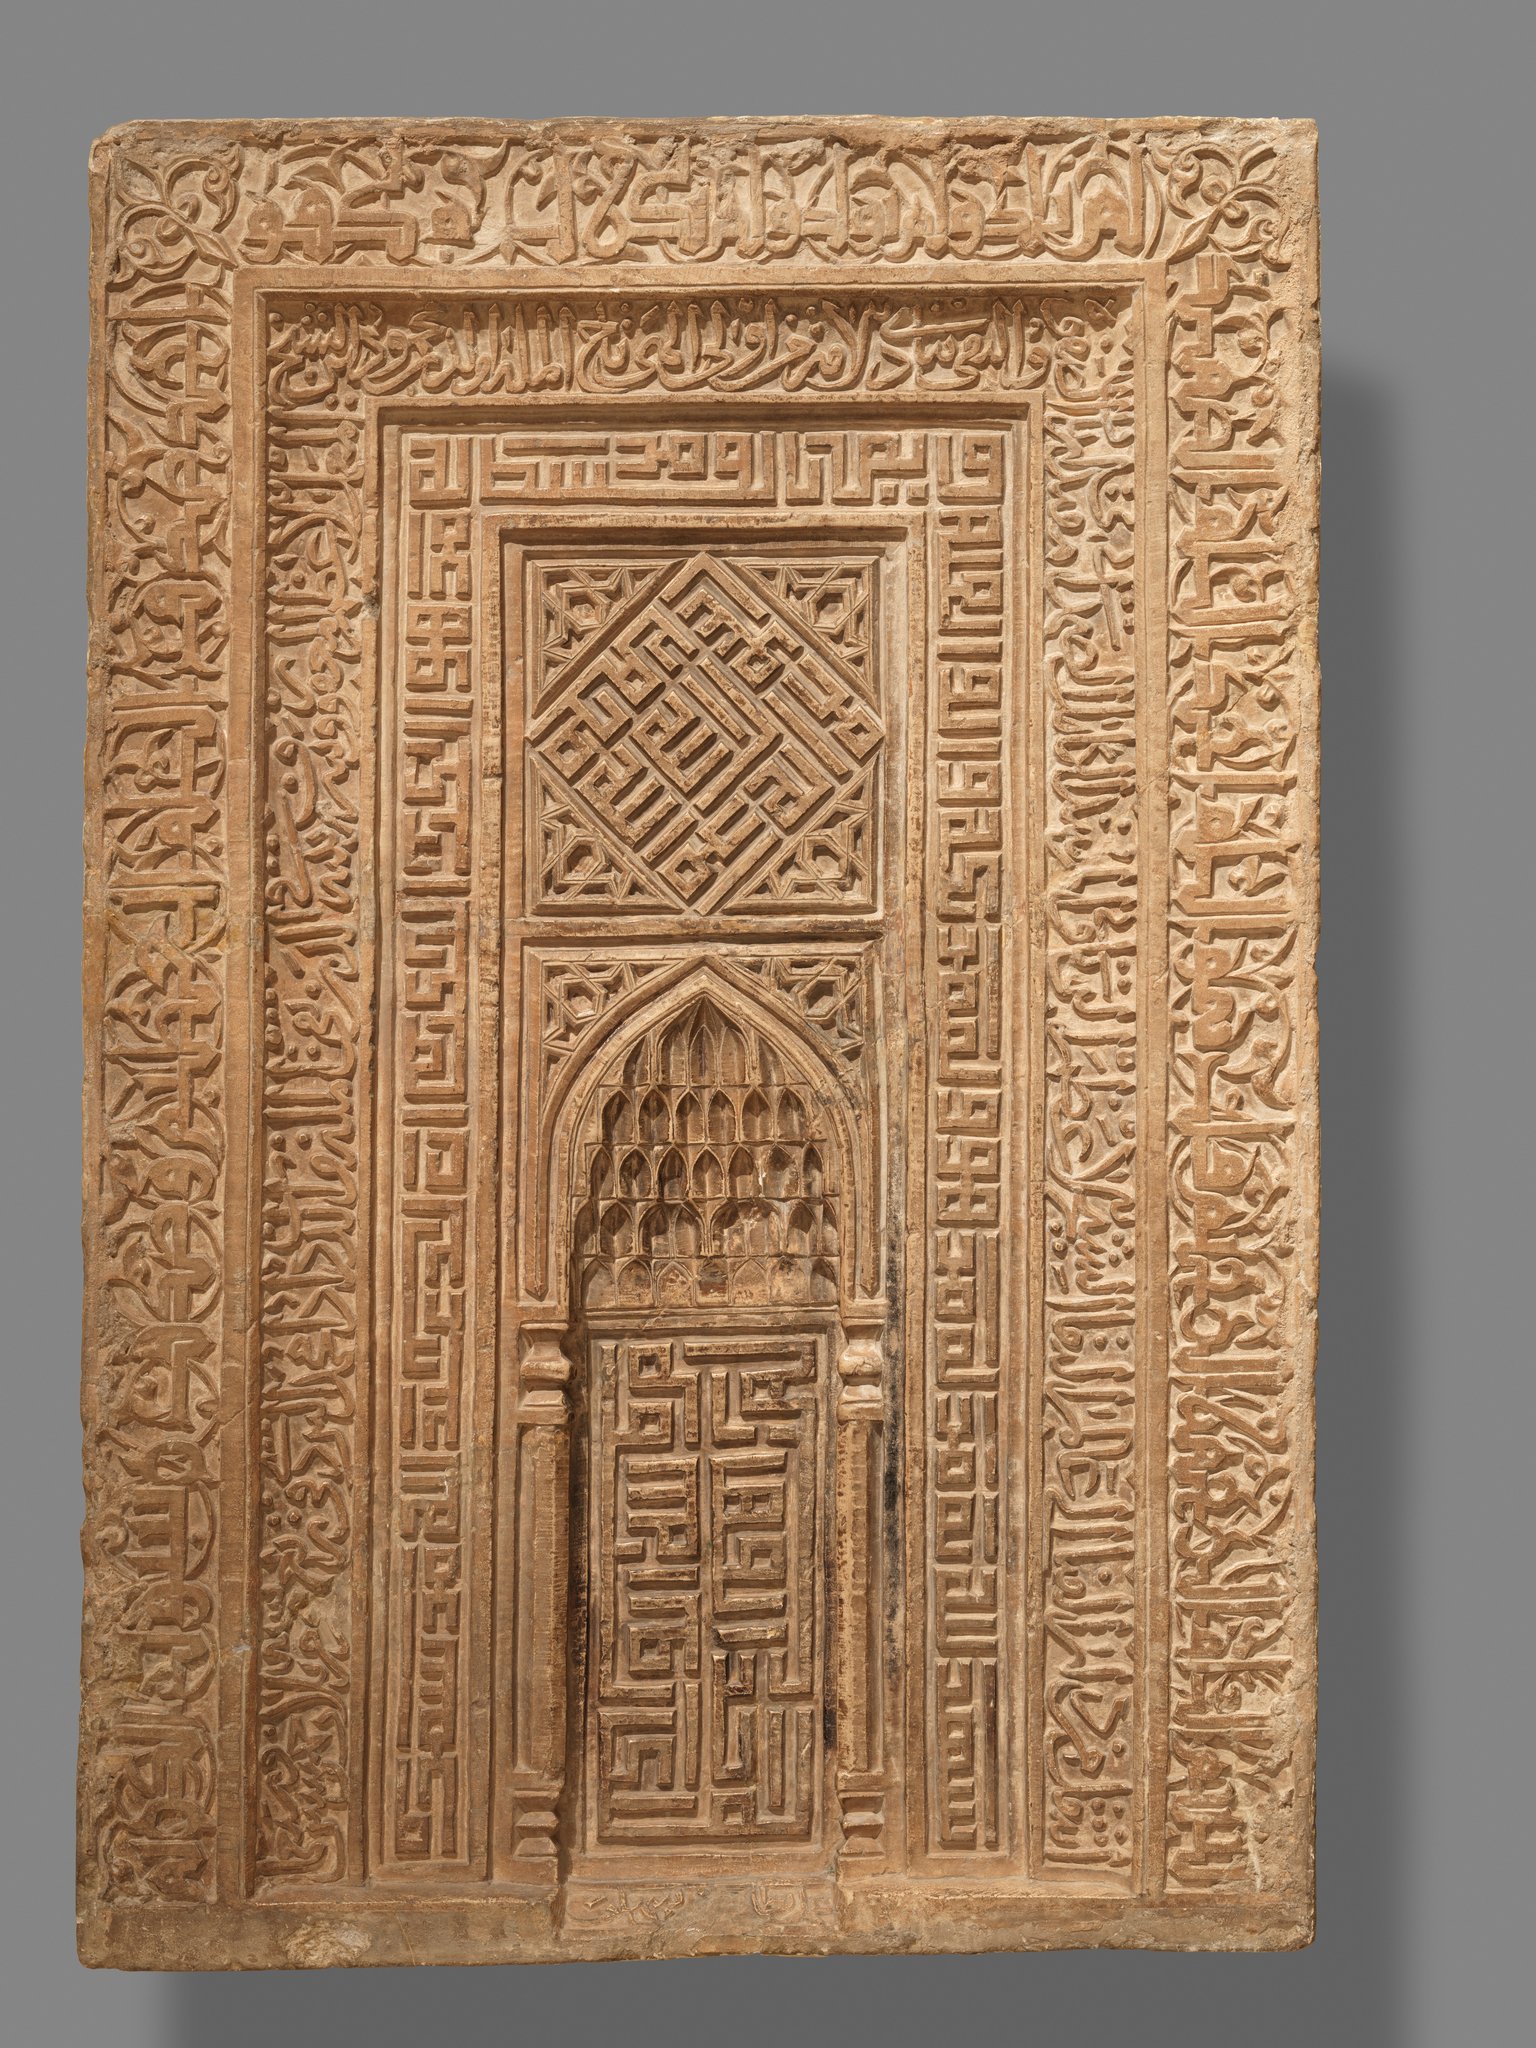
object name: tombstone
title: Tombstone in the Form of an Architectural Niche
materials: marble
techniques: carving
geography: iran